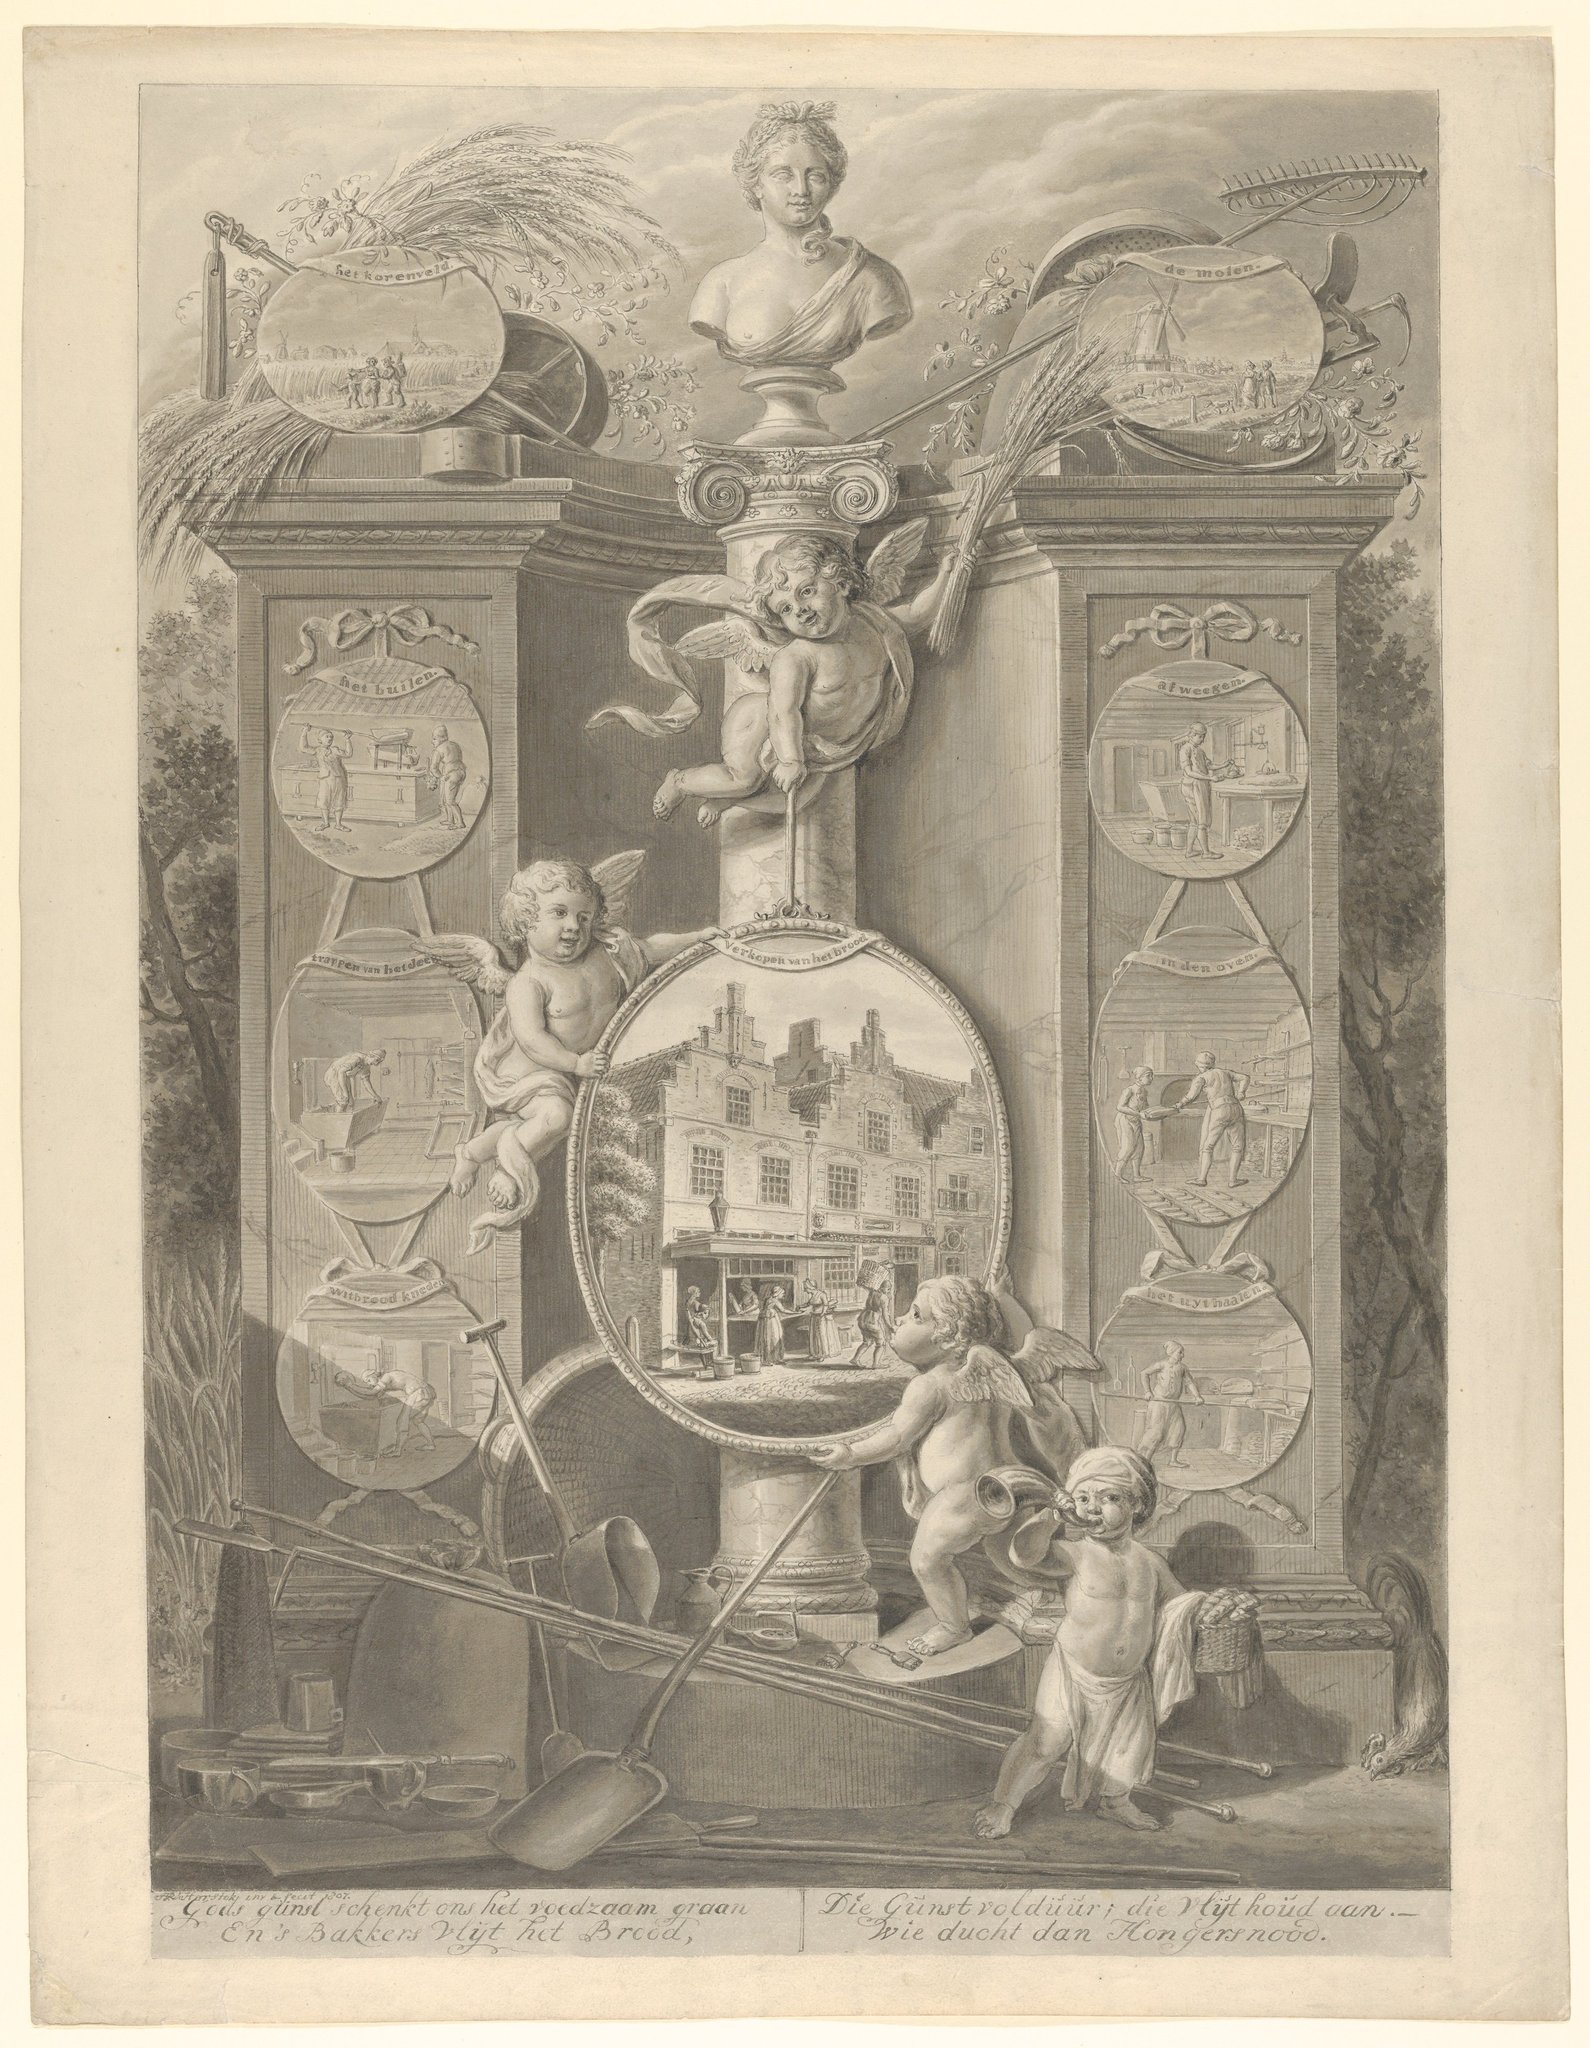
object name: drawing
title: Allegory of the Baker's Trade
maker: johannes petrus van horstok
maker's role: artist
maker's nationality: dutch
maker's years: 1745-1825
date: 1807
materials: chalk, graphite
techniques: brush, pen, wash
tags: sculpture,buildings,women